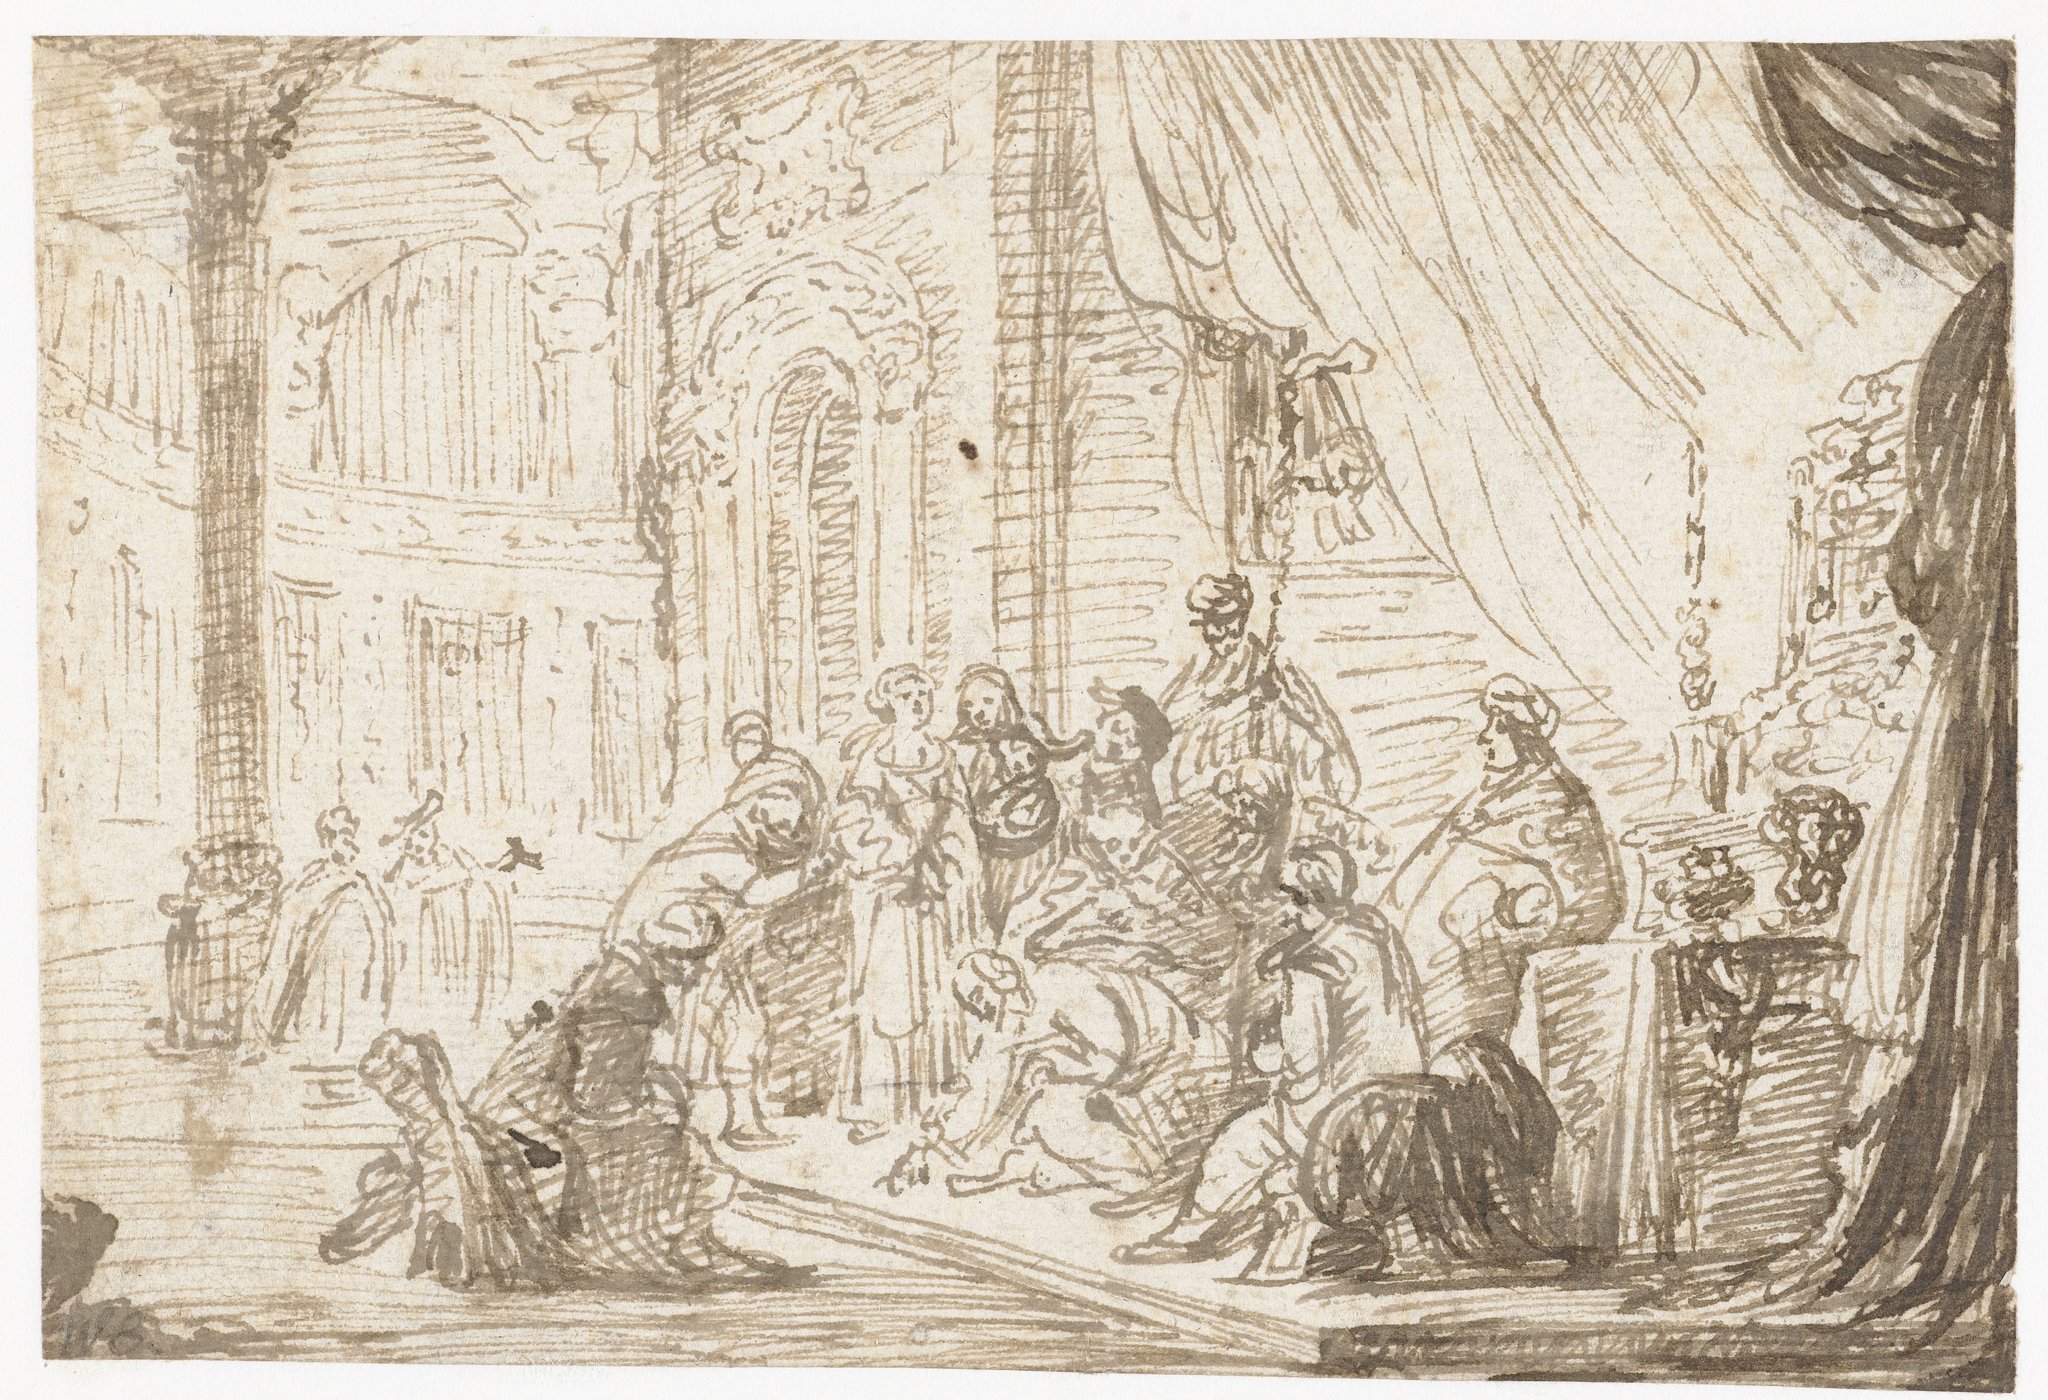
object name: drawing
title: Christus en de overspelige vrouw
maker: jacob de wet (ii)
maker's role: draughtsman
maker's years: 1640-1697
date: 1650-1697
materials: ink, paper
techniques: pen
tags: christ points to or writes on the ground